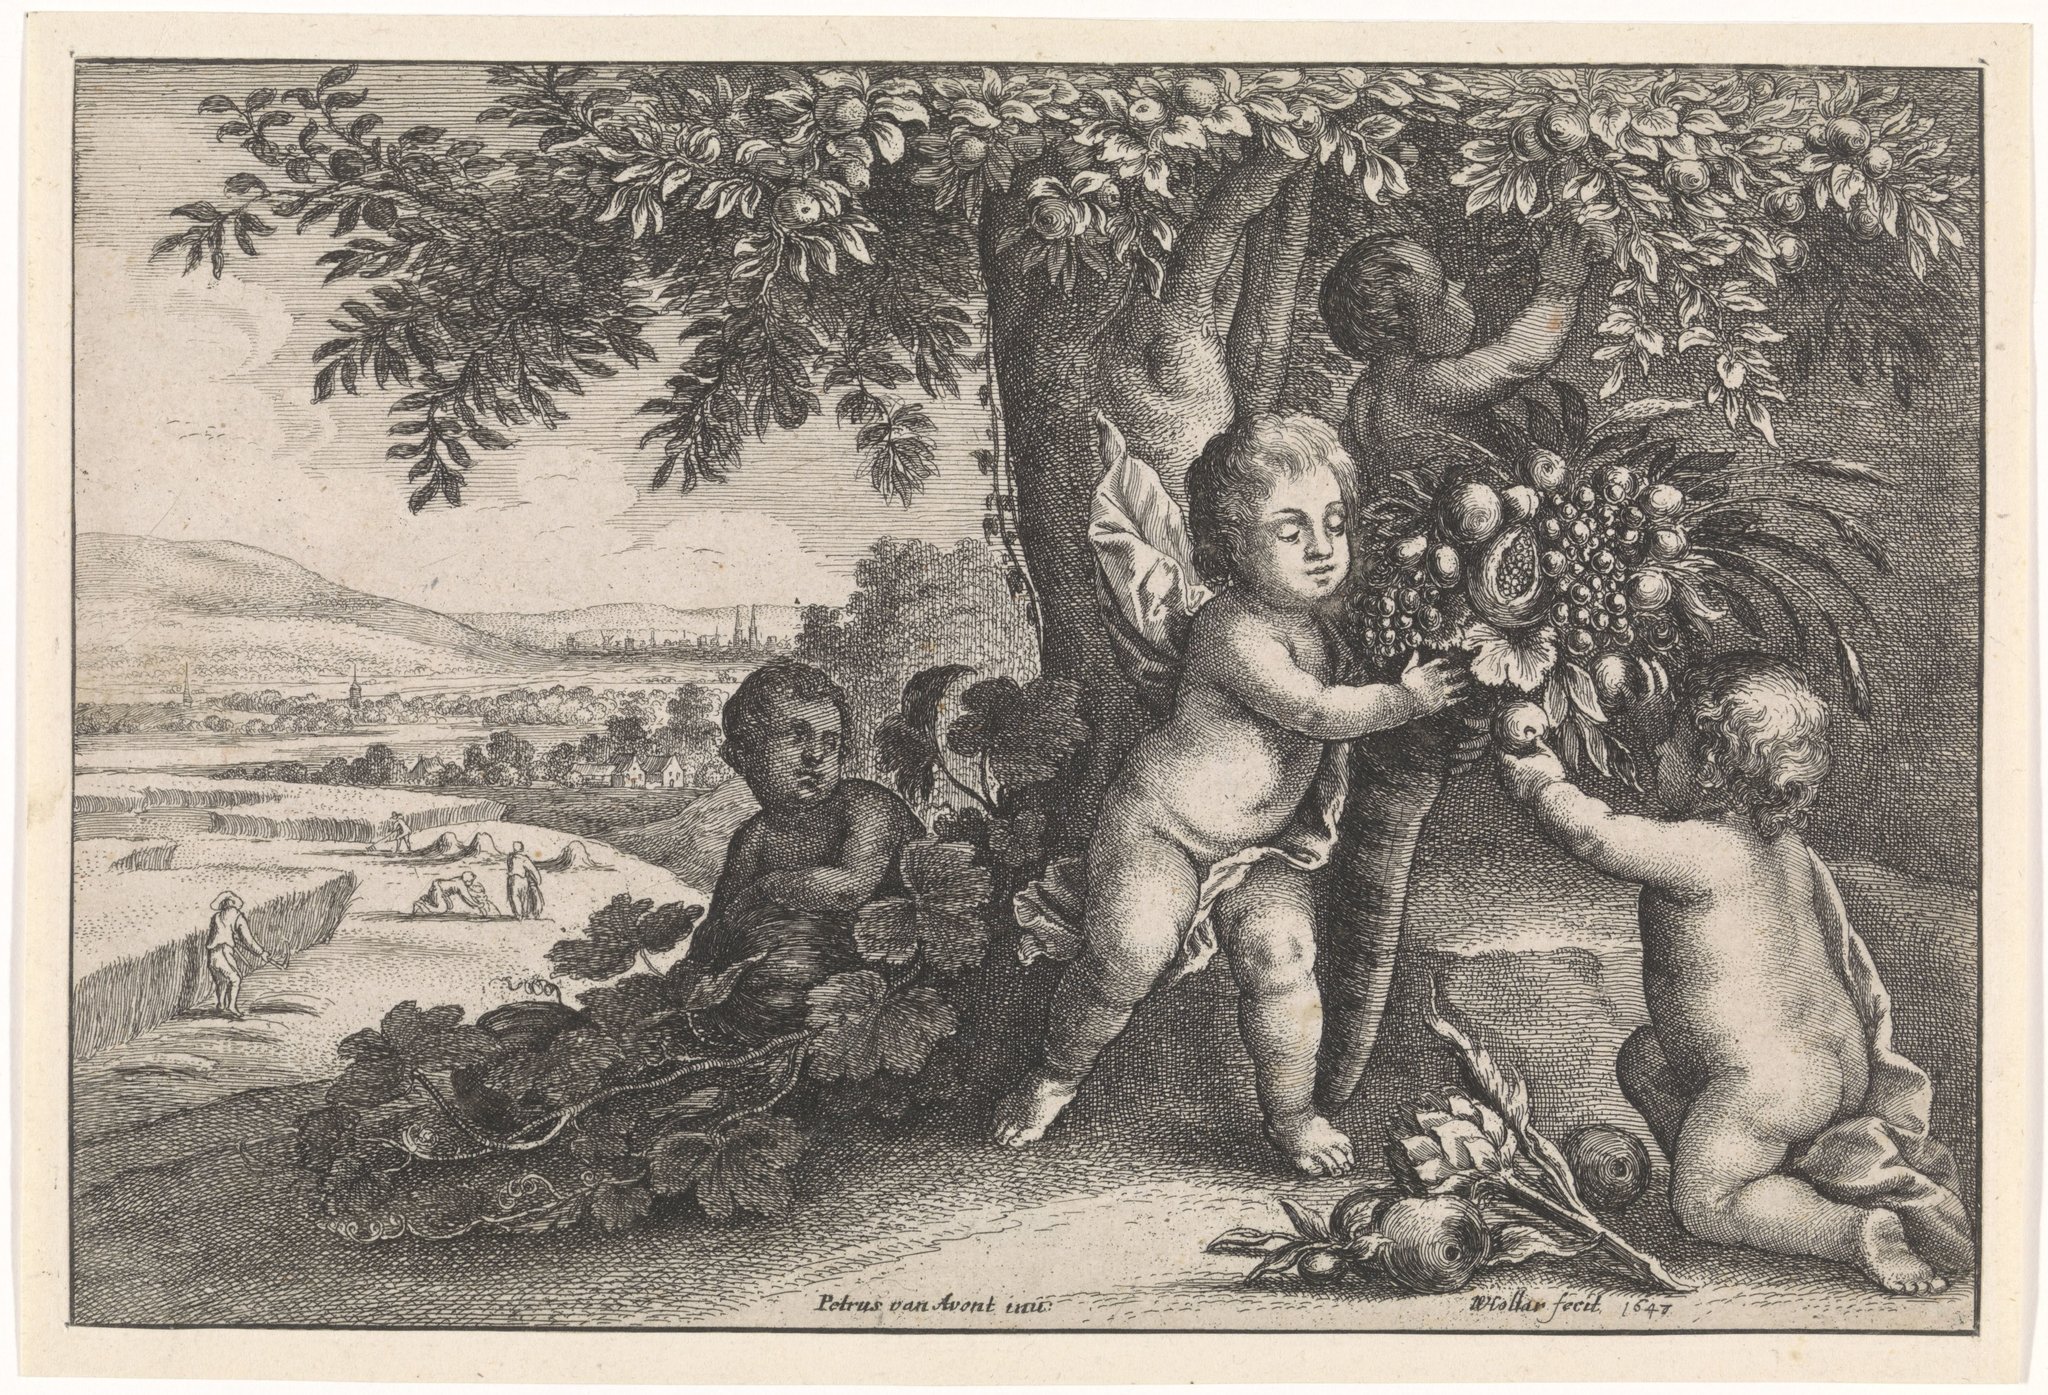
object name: print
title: Vier elementen met putti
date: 1647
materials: paper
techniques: etching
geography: antwerp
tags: 'cornucopia', horn of plenty, earth (one of the four elements), cupids: 'amores', 'amoretti', 'putti'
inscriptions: collector's mark: Lugt 2228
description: Op de voorgrond overhandigt een putto de hoorn des overvloeds aan een andere, geknielde, putto. Achter hen twee putti bij een boom. Op de achtergrond links de graanoogst. De prent maakt deel uit van een vierdelige serie met de vier elementen als onderwerp.